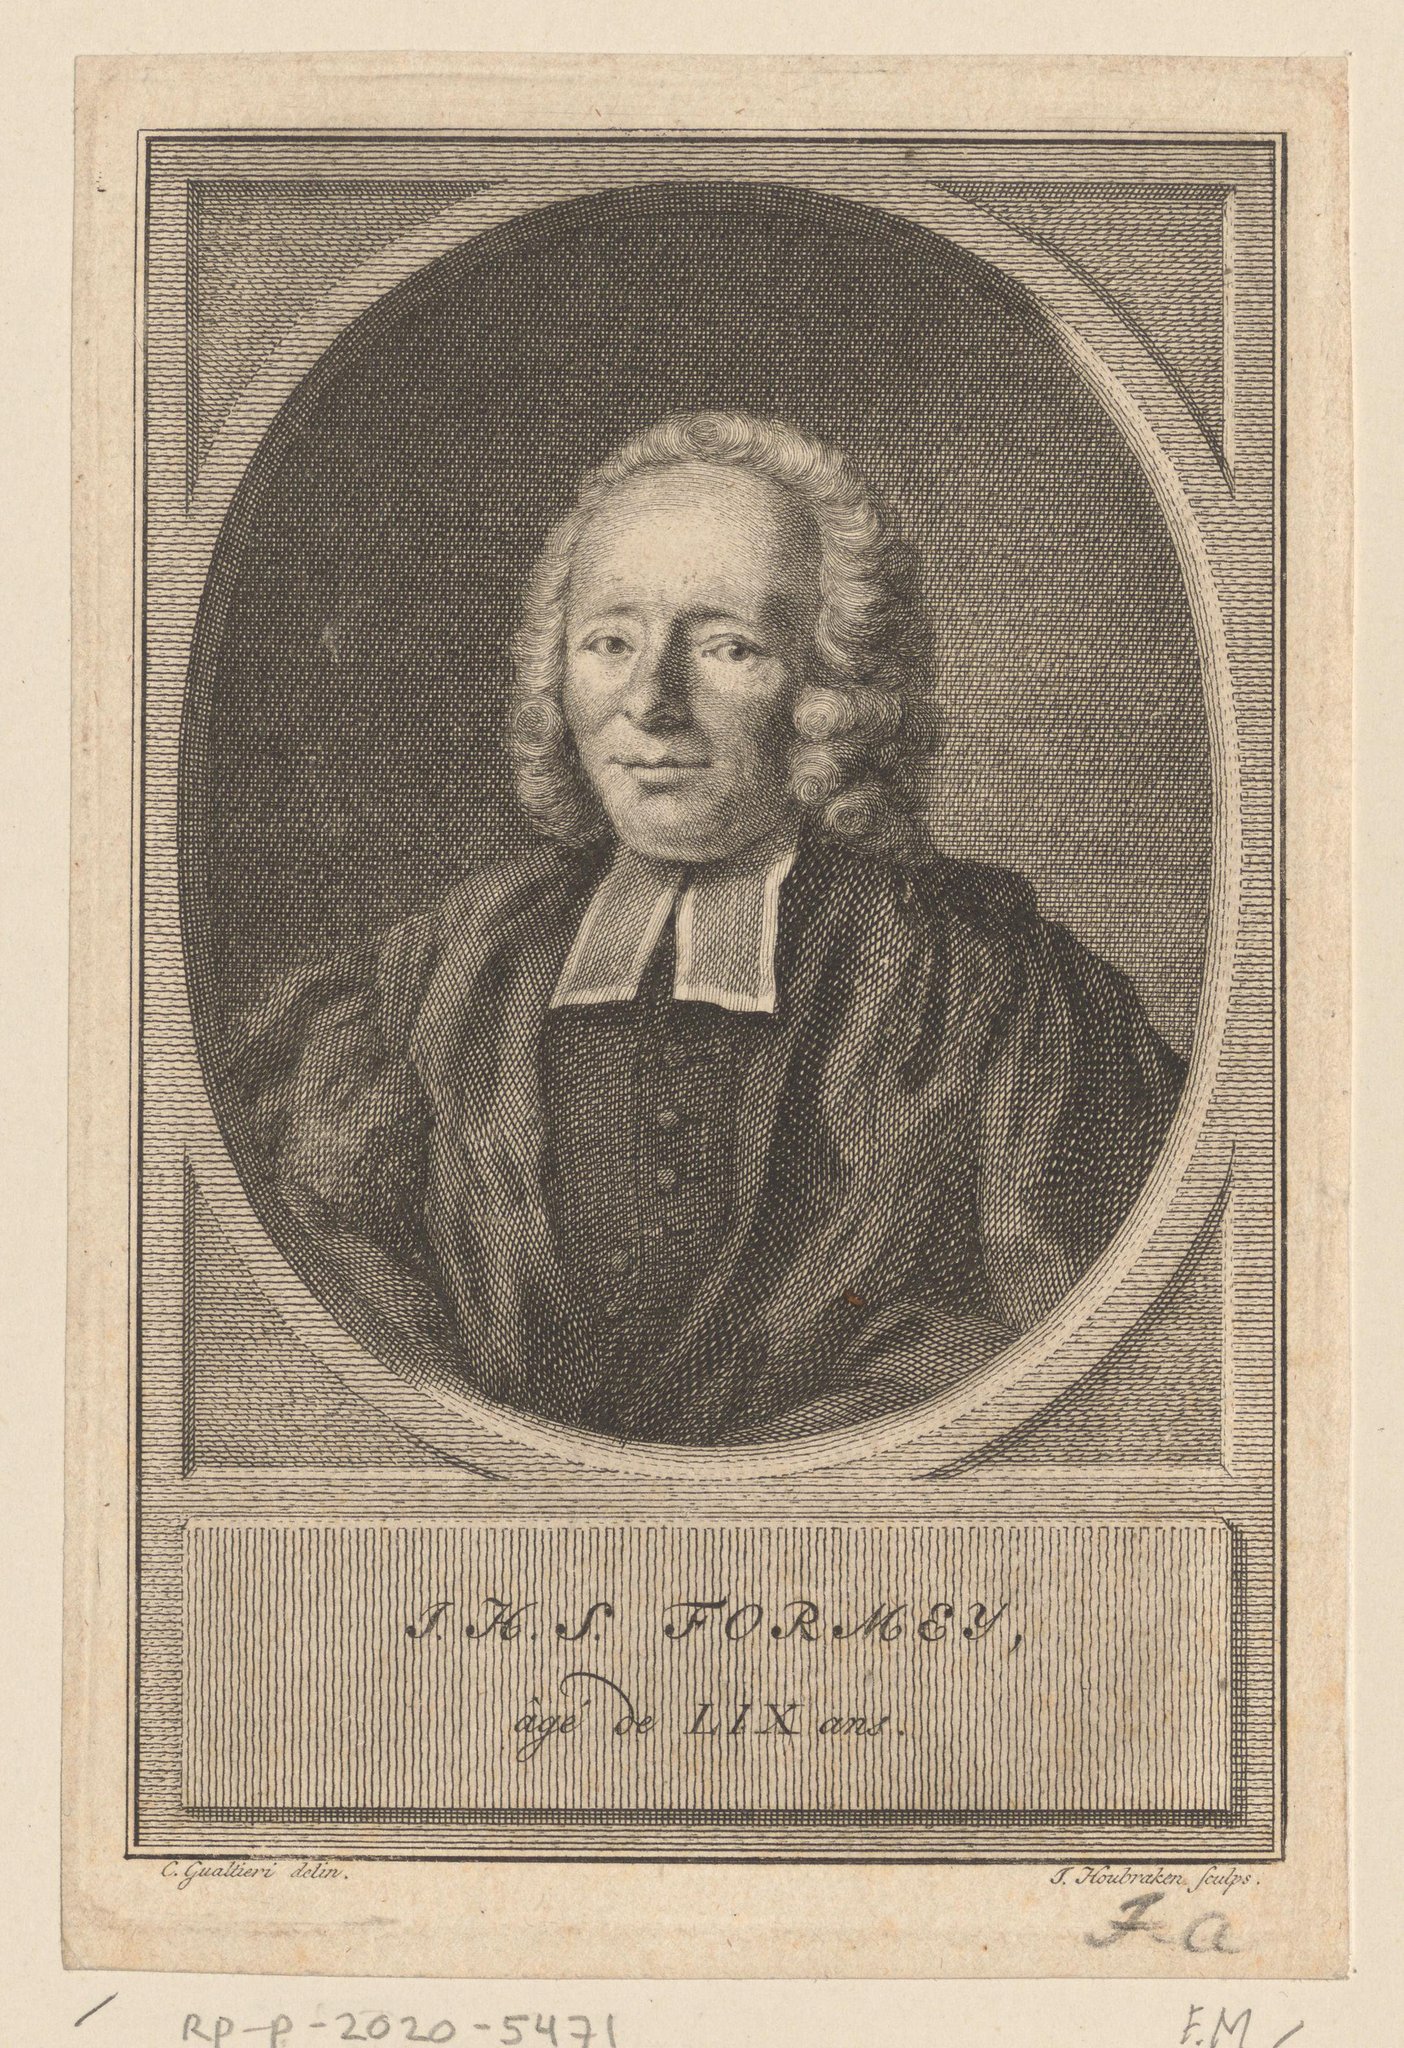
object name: print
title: Portret van Johann Heinrich Samuel Formey op 59-jarige leeftijd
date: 1770-1780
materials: paper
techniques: engraving, etching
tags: berlin, historical persons, portrait of a writer